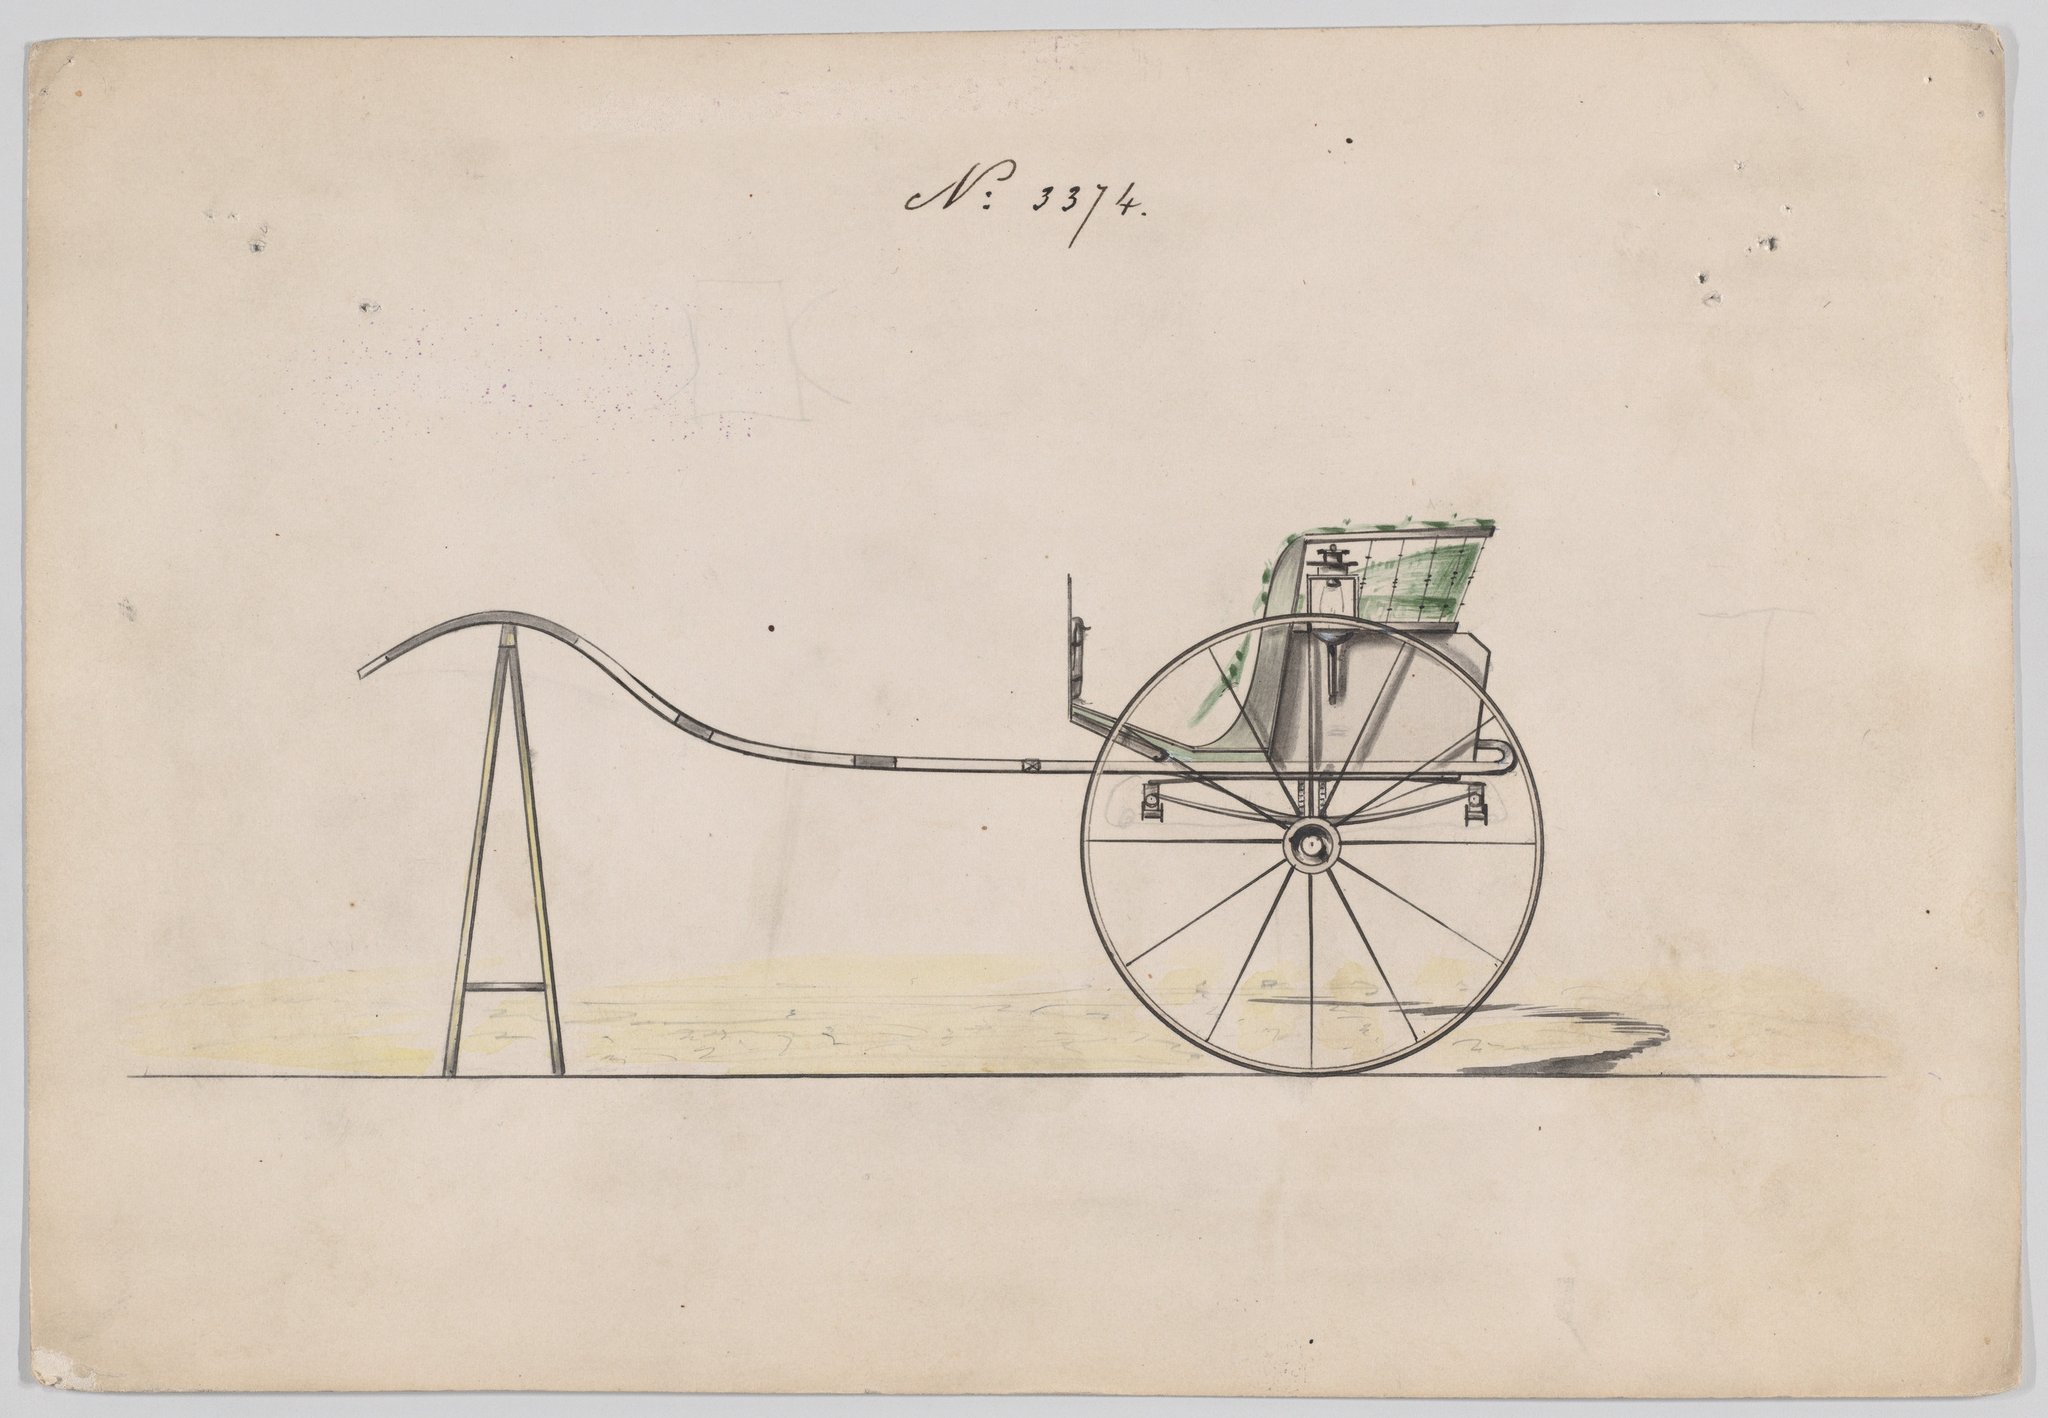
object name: drawing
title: Stanhope Gig # 3374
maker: brewster & co.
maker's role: manufacturer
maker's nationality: american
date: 1877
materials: gouache, gum arabic, ink, watercolor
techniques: pen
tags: carriages